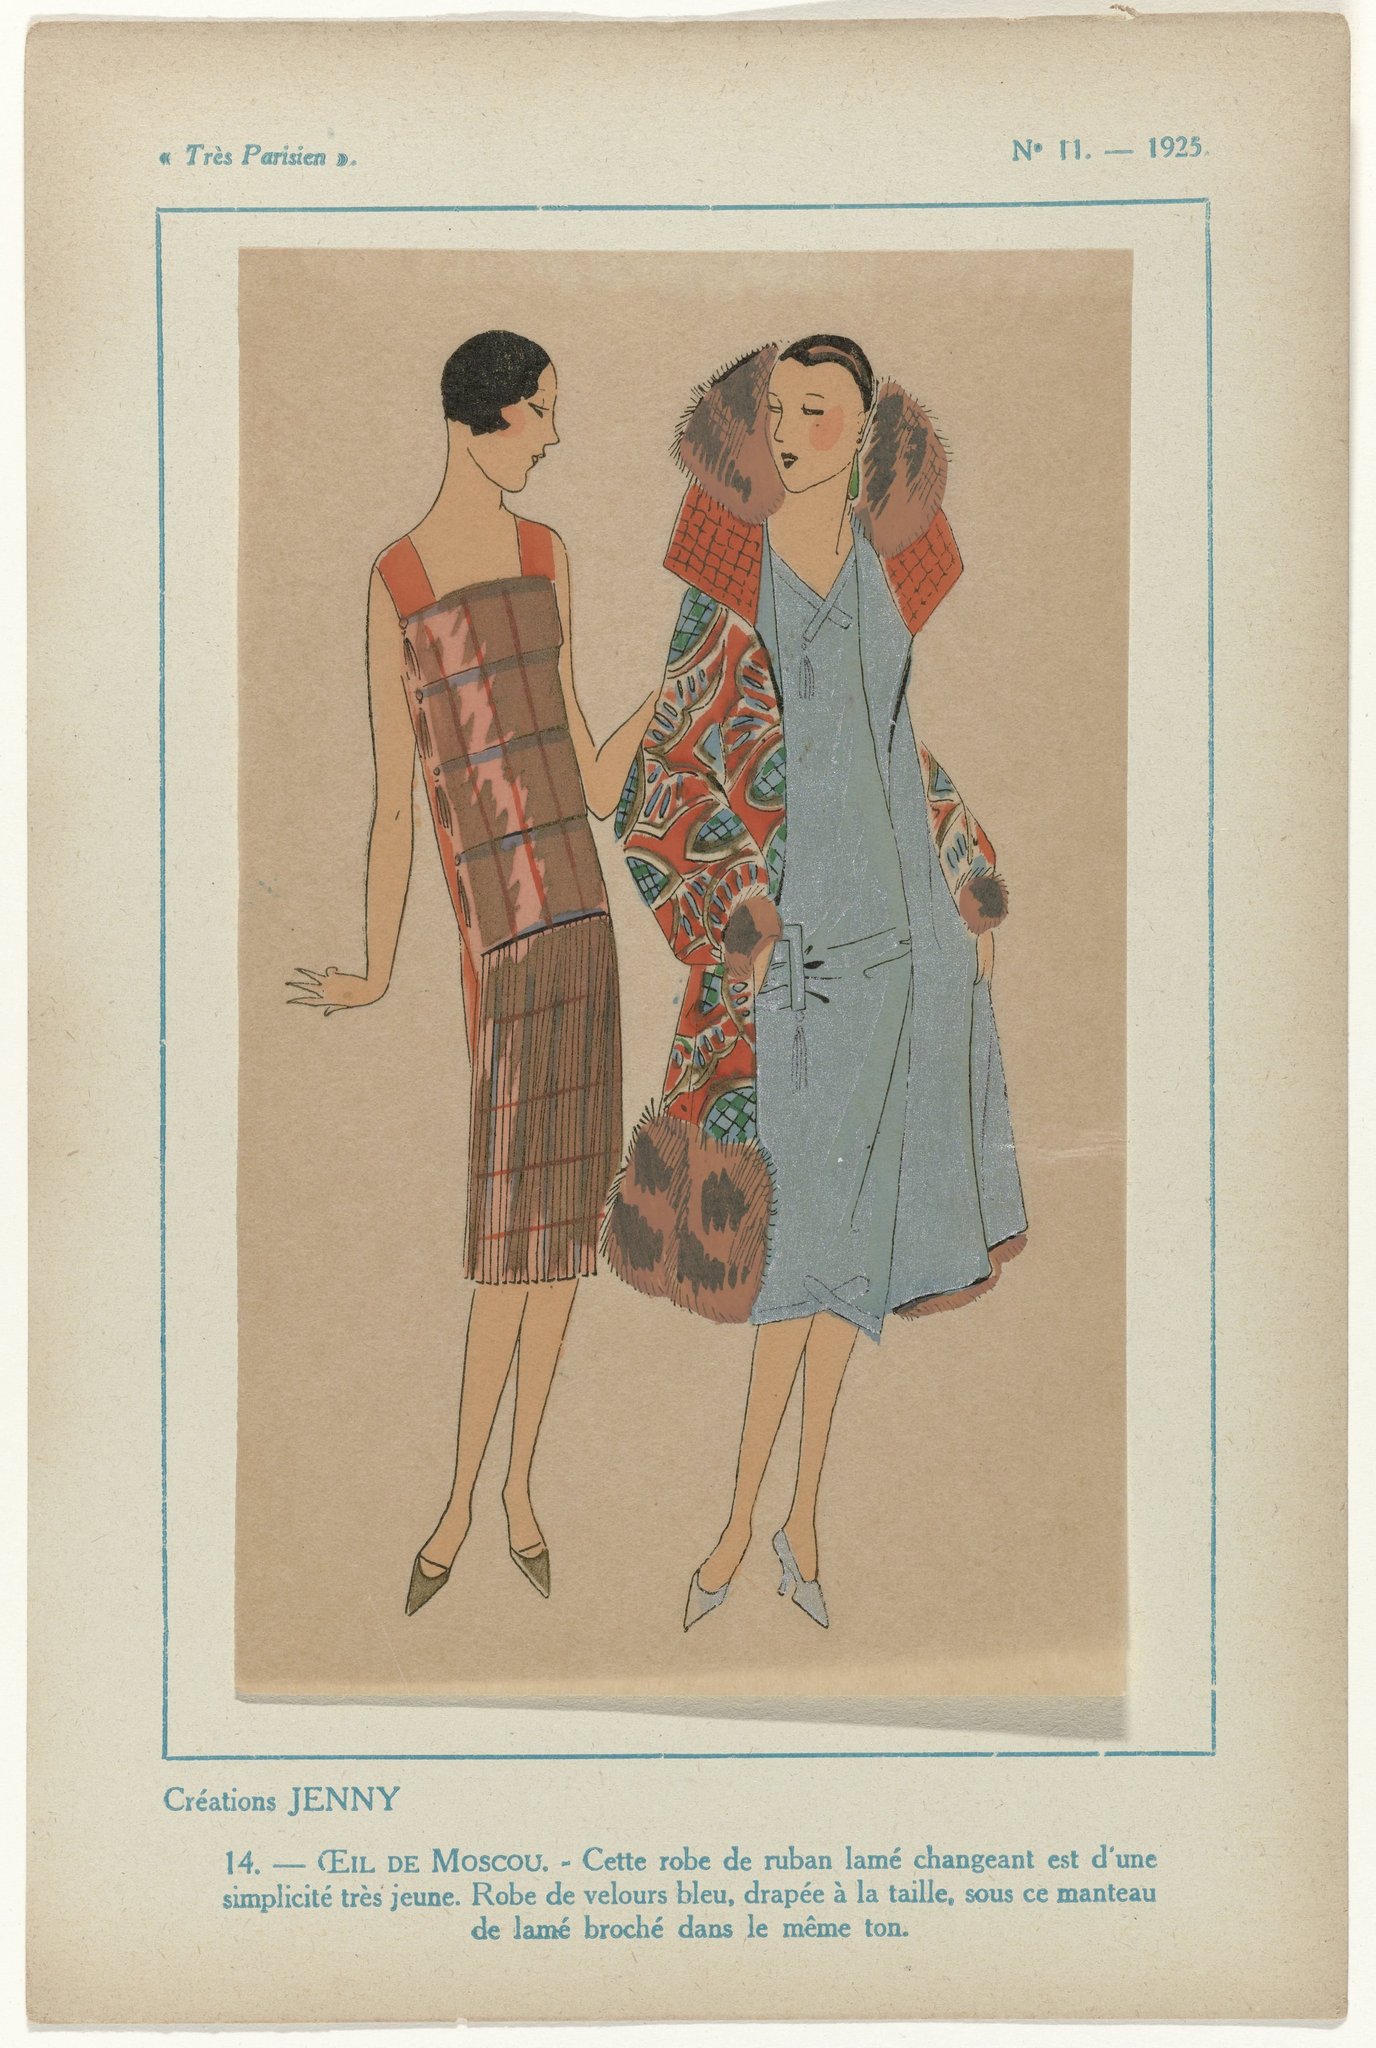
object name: fashion print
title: Très Parisien, 1925, No. 11, Pl. 14: Créations JENNY - OEIL DE MOSCOU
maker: g-p. joumard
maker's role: publisher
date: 1925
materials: paper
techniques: hand coloring, letterpress printing, lithography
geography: paris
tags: dress, gown: day dress (+ women's clothes), fashion plates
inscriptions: caption: ‘14. - OEIL DE MOSCOU. - Cette robe de ruban lamé changeant est d'une simplicité très jeune. Robe de velours bleu, drapée à la taille, sous ce manteau de lamé broché dans le même ton.’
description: Creaties van het modehuis Jenny. Japon met Prent uit het modetijdschrift Très Parisien...La Mode, Le Chic, L'Élégance (1920-1936)